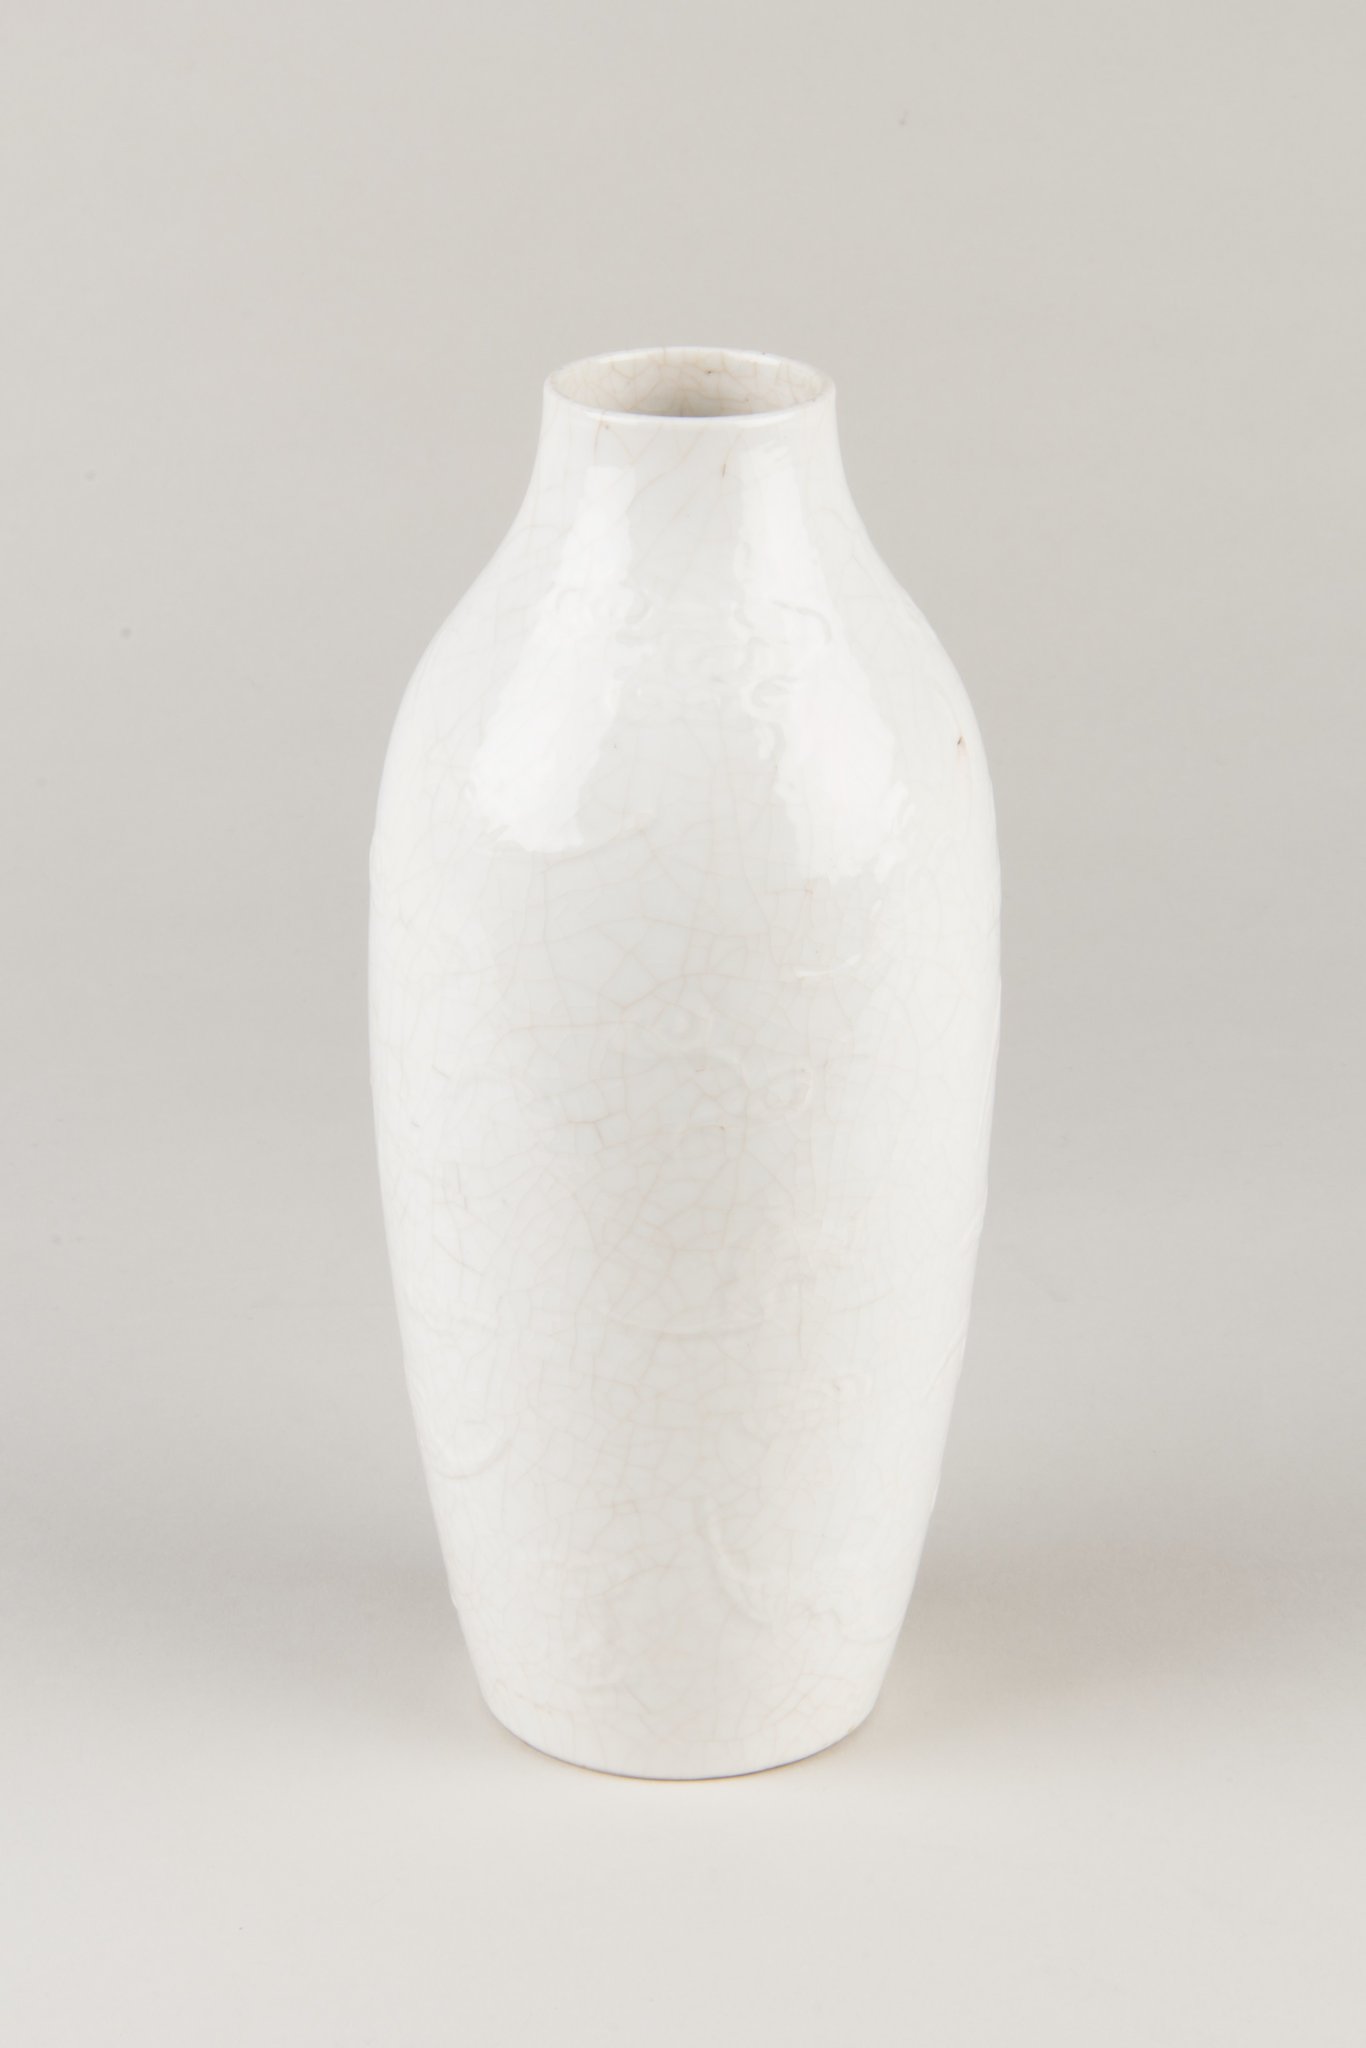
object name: vase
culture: chinese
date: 1701-1800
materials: glaze, porcelain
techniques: relief